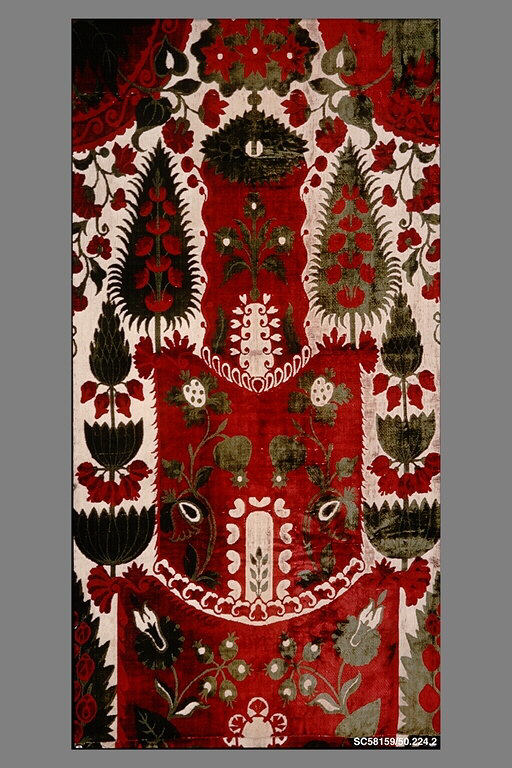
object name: piece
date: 1700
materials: silk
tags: flowers